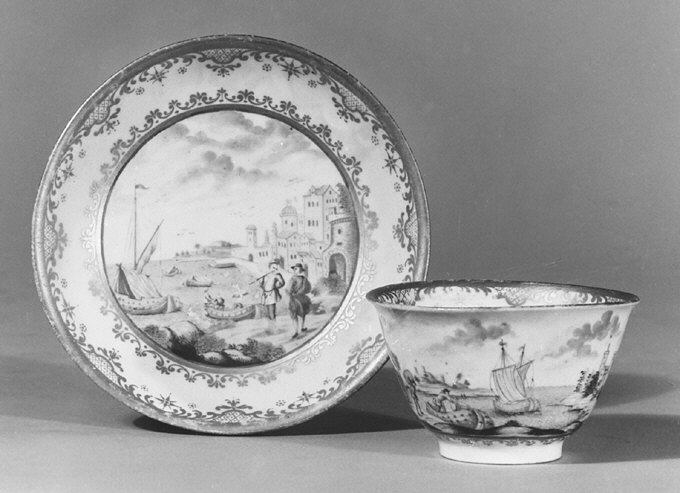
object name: cup and saucer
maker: meissen manufactory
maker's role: manufactory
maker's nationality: german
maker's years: 1710-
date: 1735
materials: hard paste porcelain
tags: men,boats